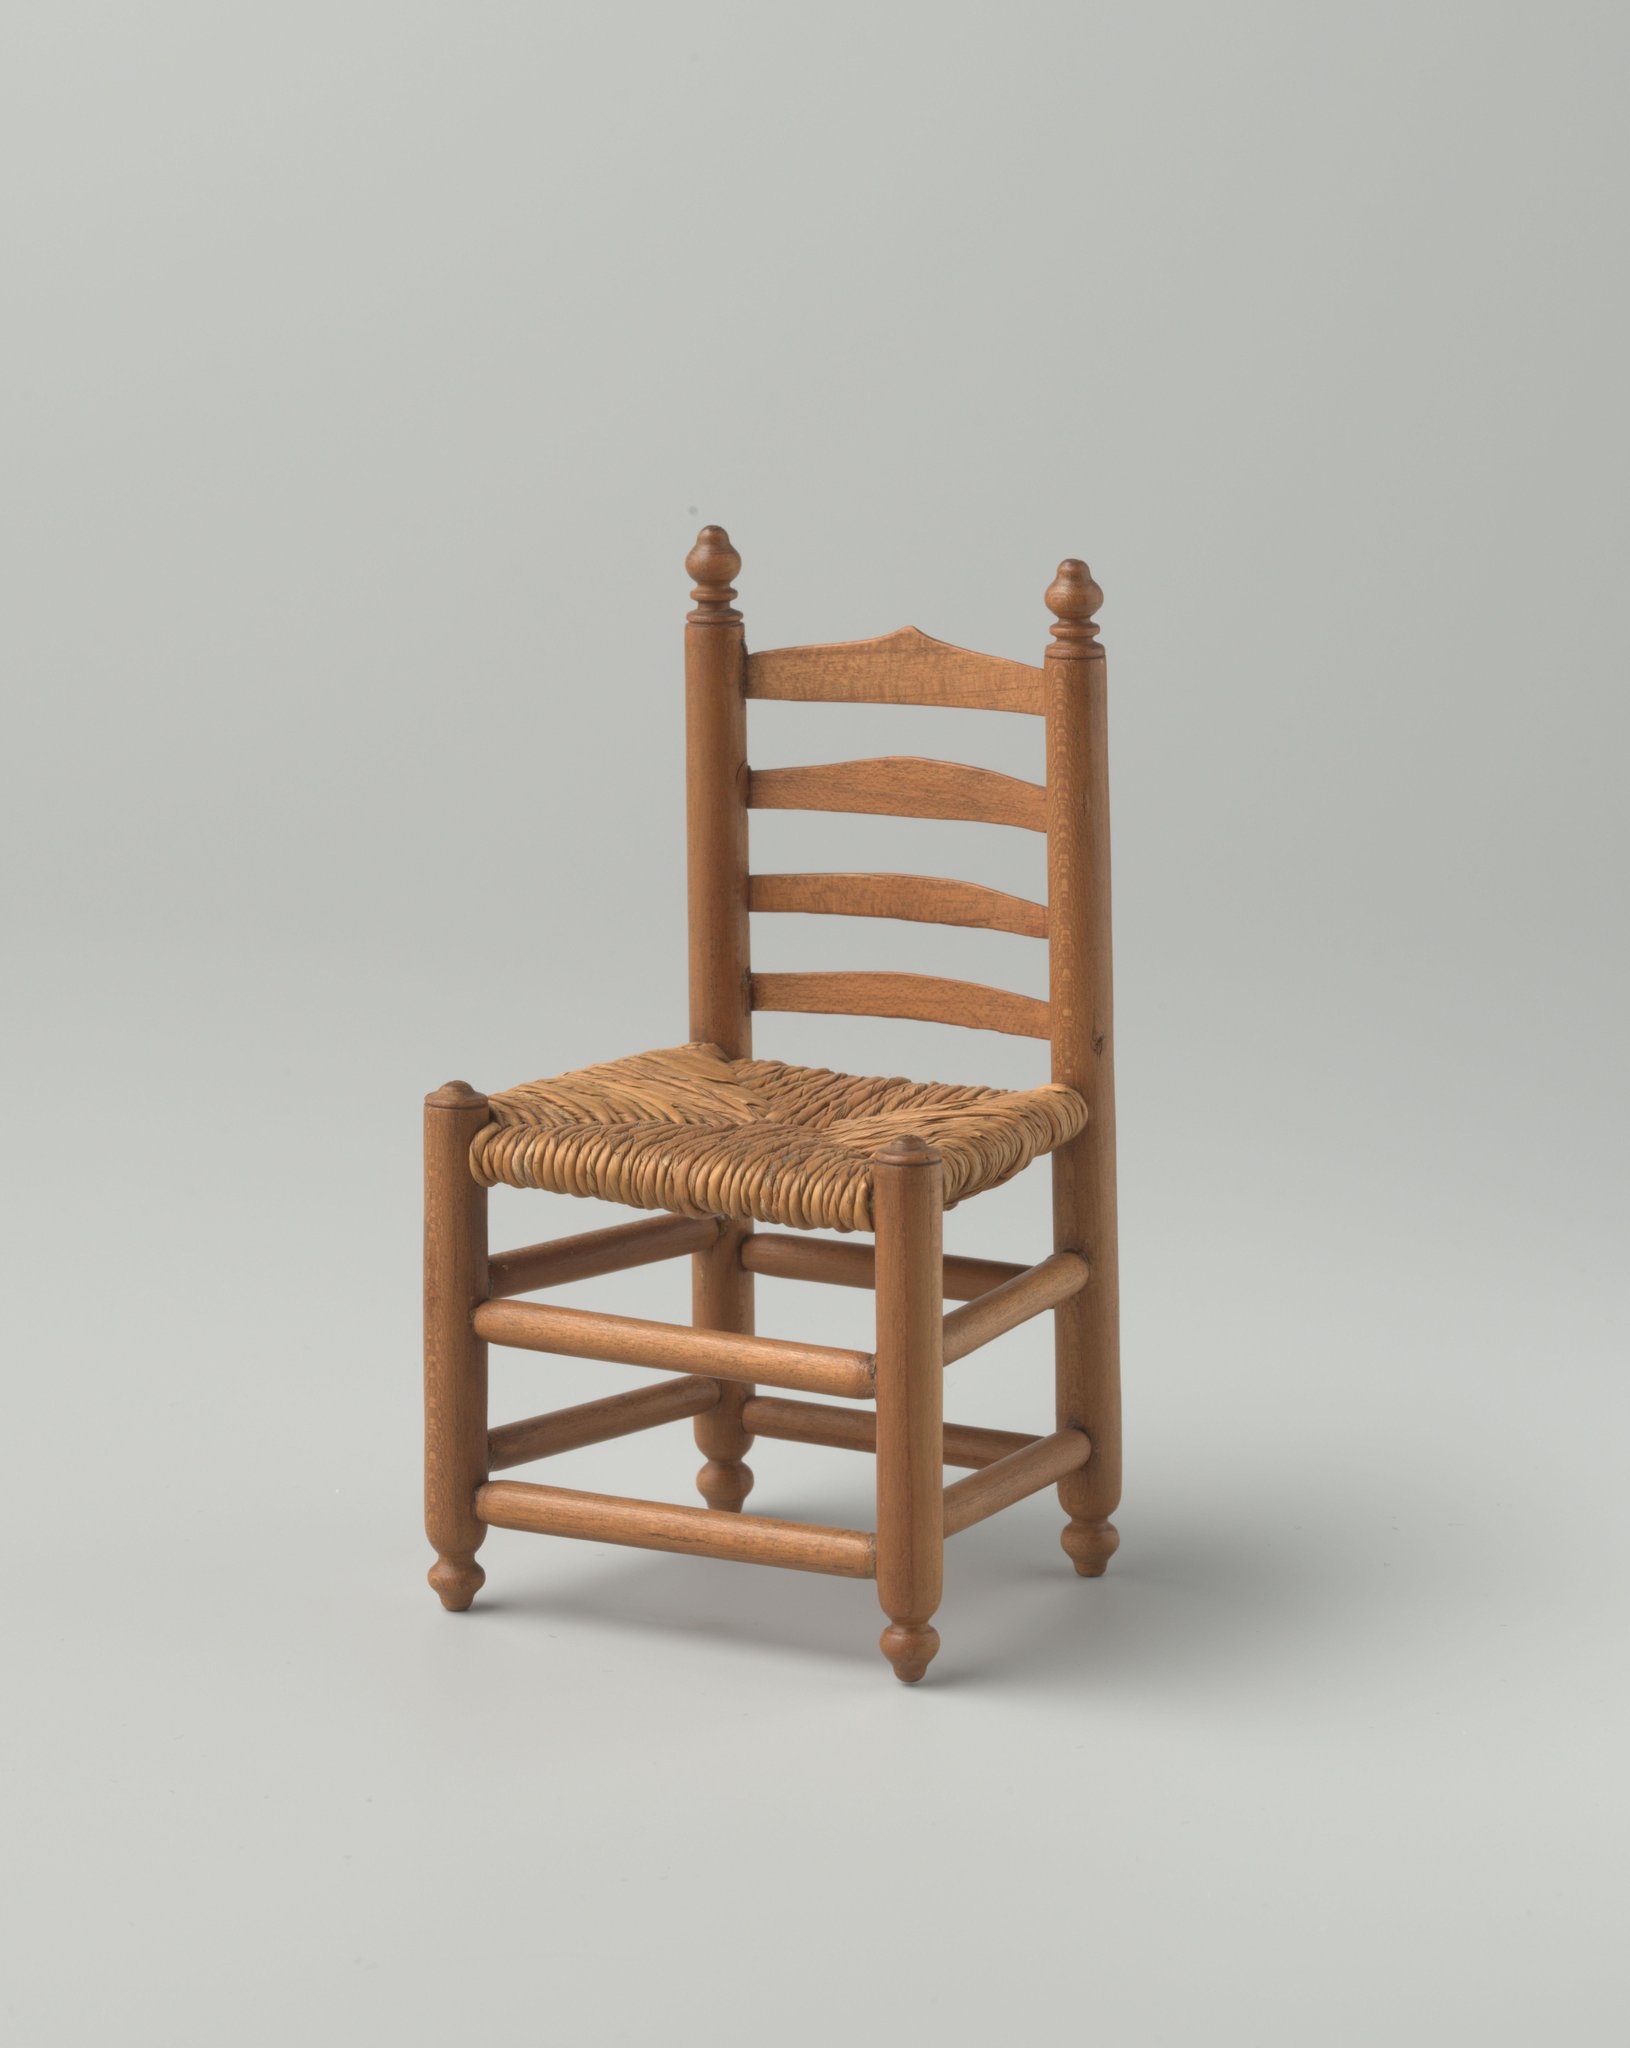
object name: knopstoel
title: Knopstoel vervaardigd van esdoornhout met gladde, gedraaide stijlen en dwarsregels, voorpoten en achterstijlen eindid in fijn gedraaide knoppen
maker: Anonymous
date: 1690-1710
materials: wood, fiber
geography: amsterdam